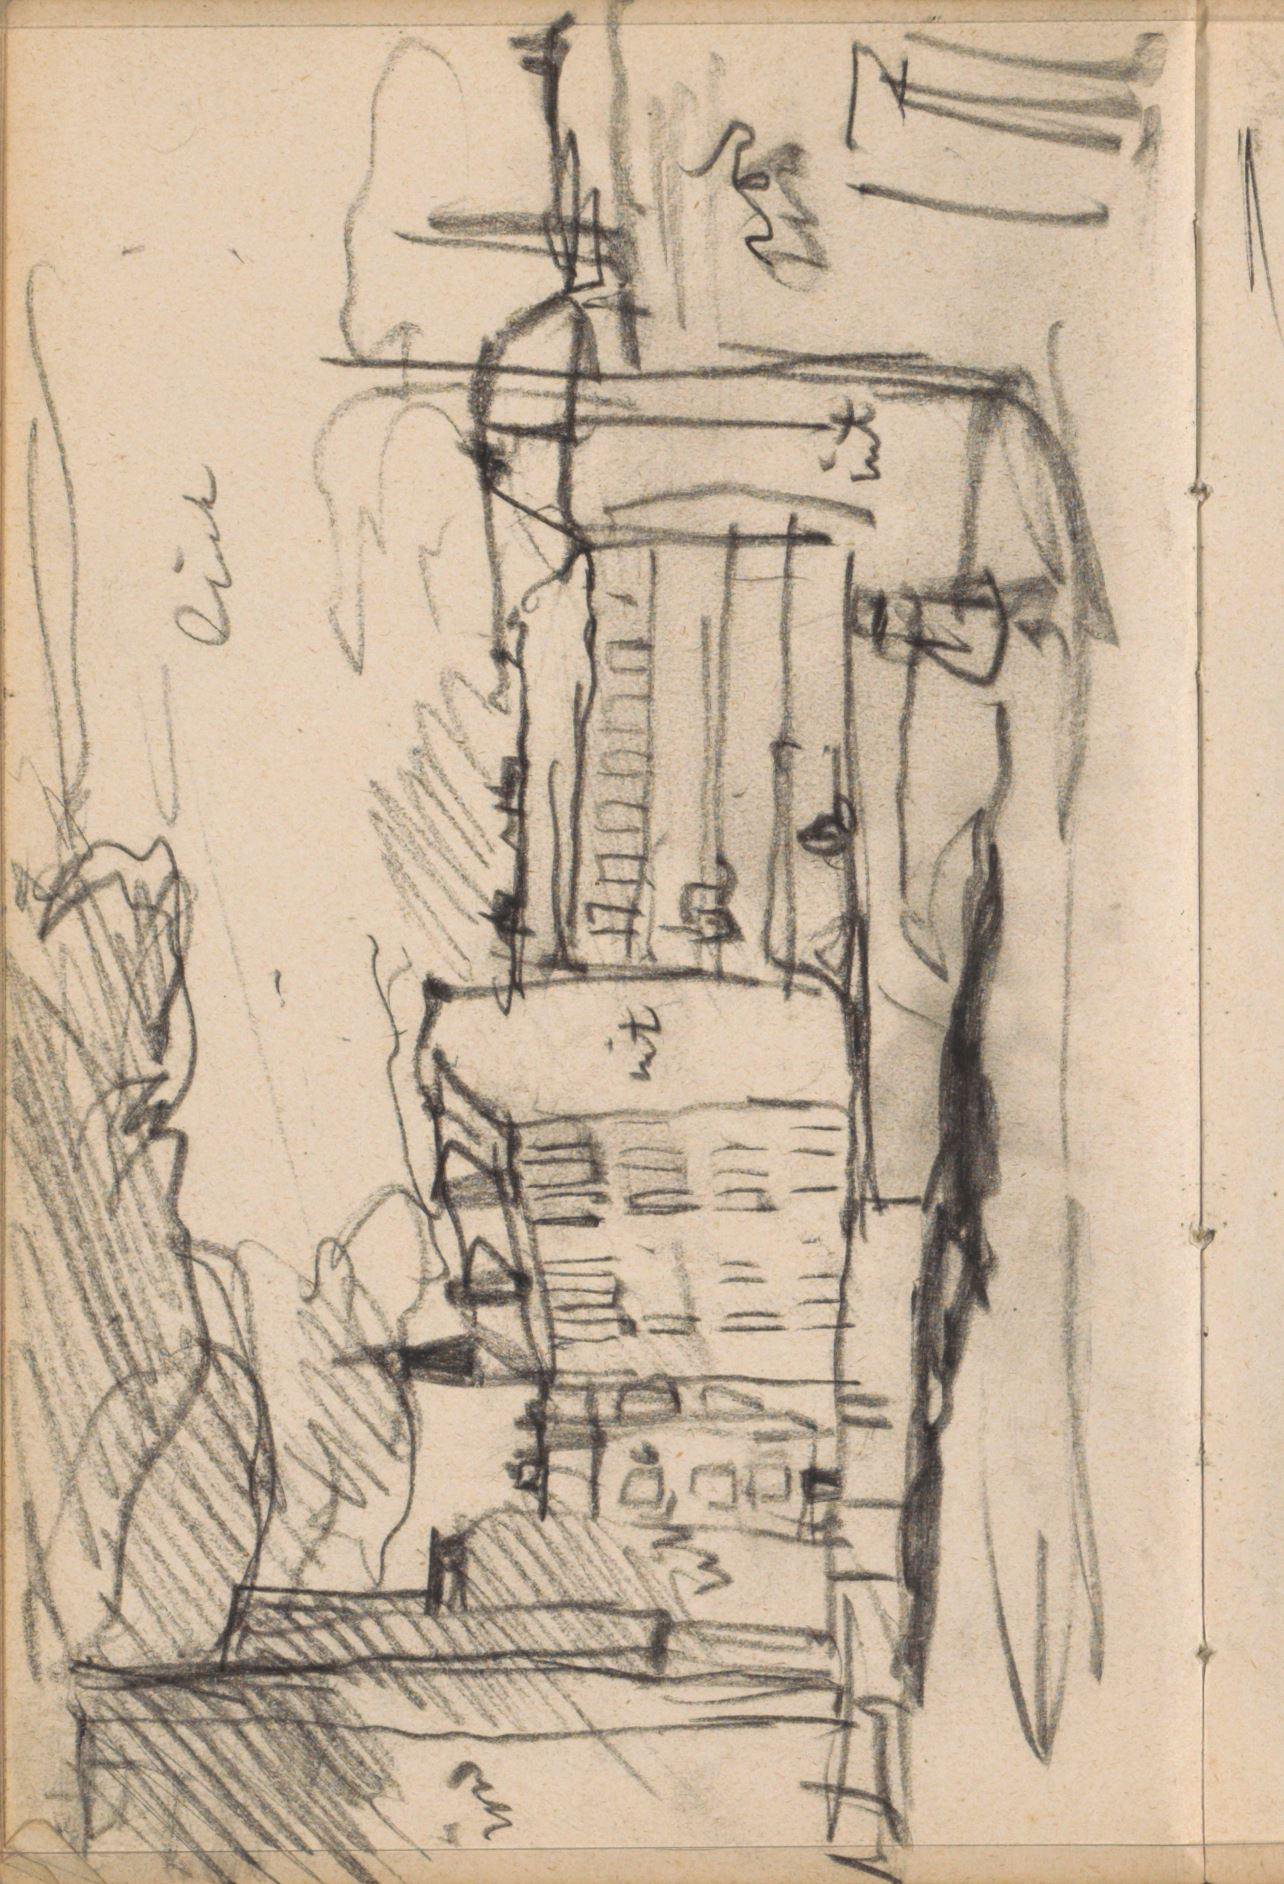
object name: sketchbook leaf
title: Gezicht in Amsterdam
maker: george hendrik breitner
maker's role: draughtsman, painter, print maker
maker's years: 1857-1923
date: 1902-1914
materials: paper, pencil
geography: amsterdam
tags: urban housing, street, amsterdam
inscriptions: kleurnotitie, handgeschreven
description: Gezicht in Amsterdam. Pagina 31 uit een schetsboek met 46 bladen vervaardigd te Noord-Holland en Utrecht.